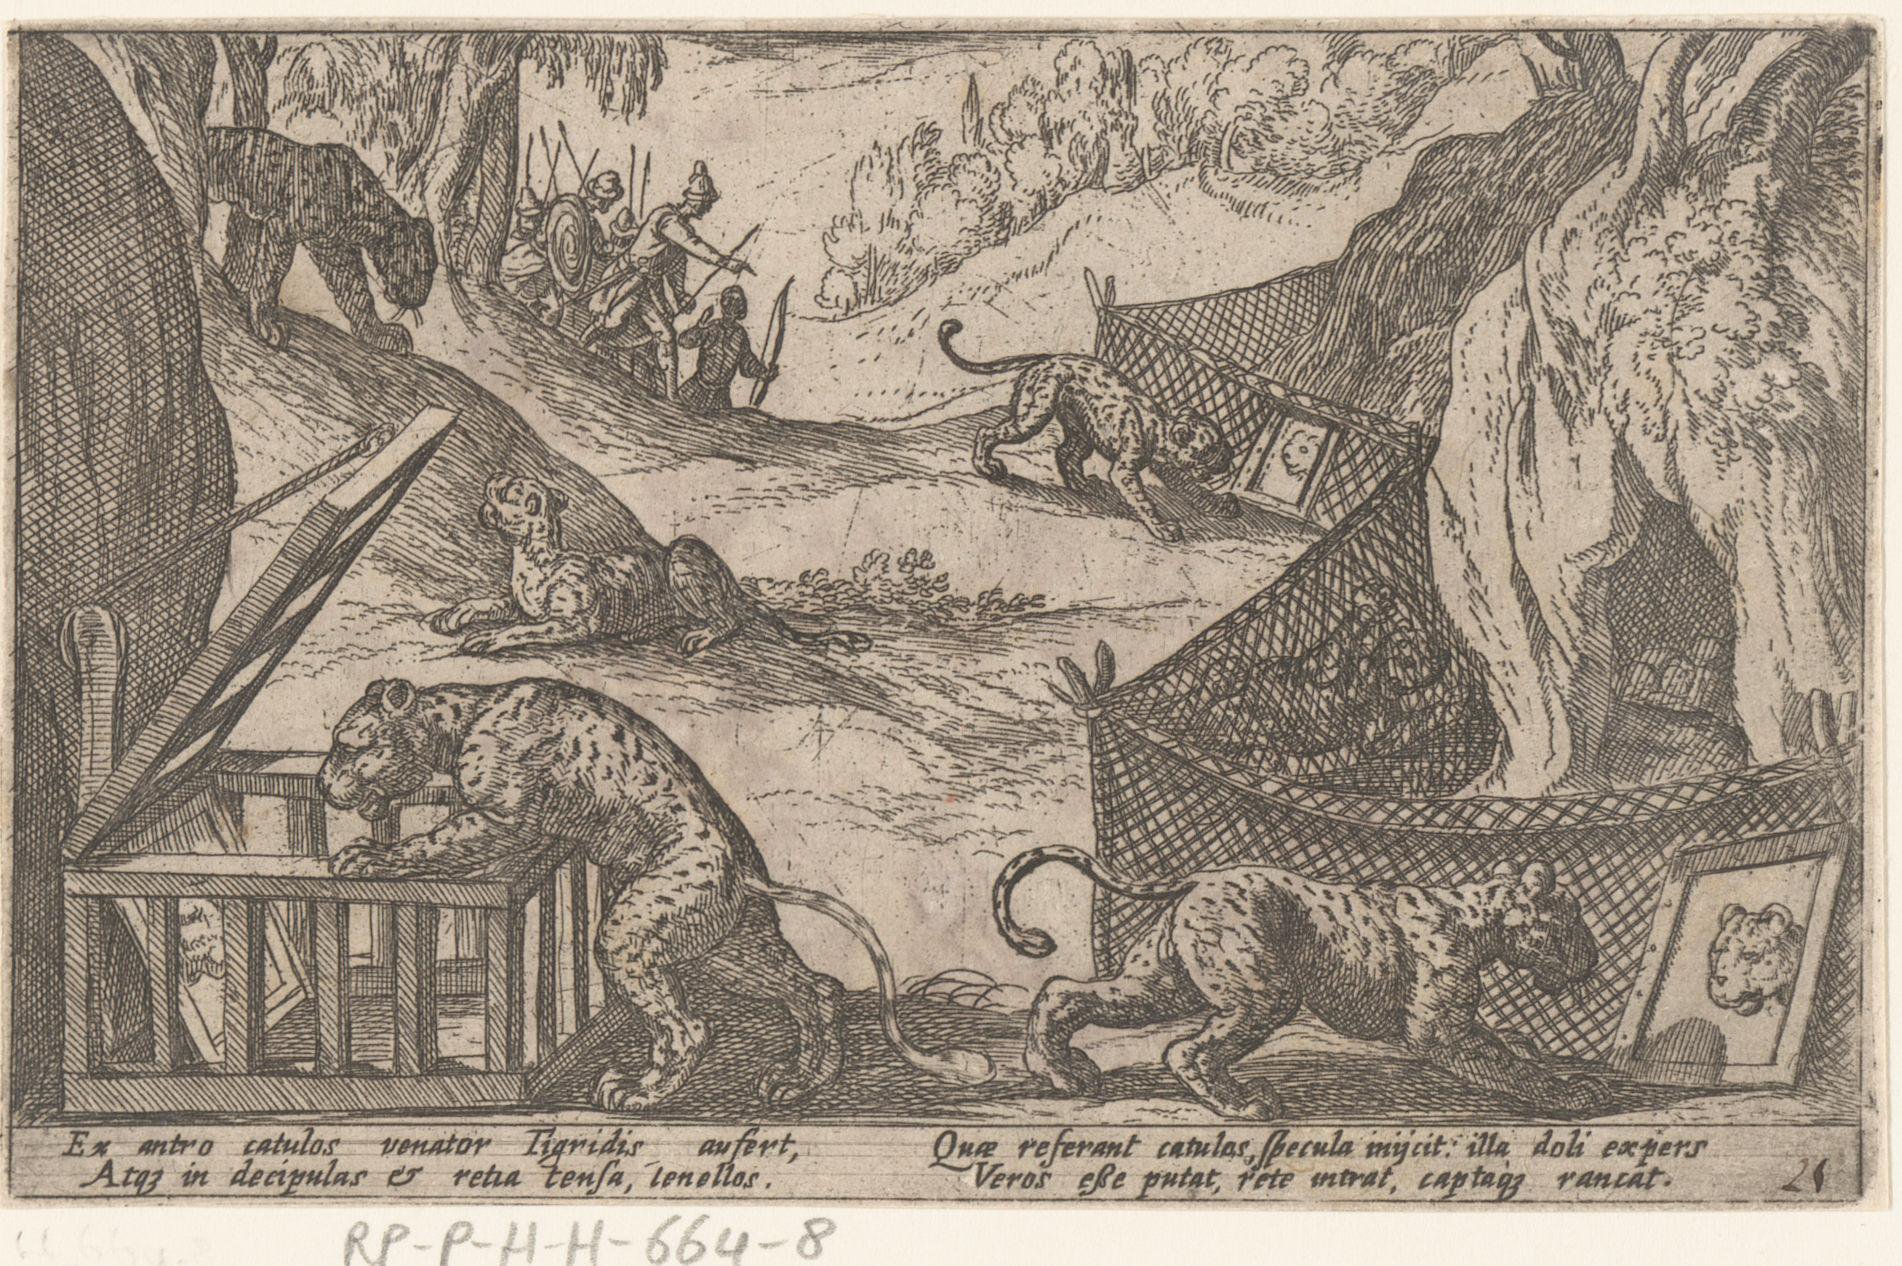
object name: print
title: Venationes Ferarum, Avium, Piscium Pugnae bestiariorum: et mutuae bestiarum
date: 1605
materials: paper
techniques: etching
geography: italy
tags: beasts of prey, predatory animals: leopard, mirror, hunter, hunters hunting (n.b.: in 1988-1990 this notation denoted the concept of 43c11421 'hunters resting during the hunt'), reflection (in a mirror)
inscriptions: collector's mark: ‘Hinloopen’, number: ‘21’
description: Landschap met jagers die luipaarden vangen met behulp van verschillende vallen met spiegels. Tekst in het Latijn in ondermarge.